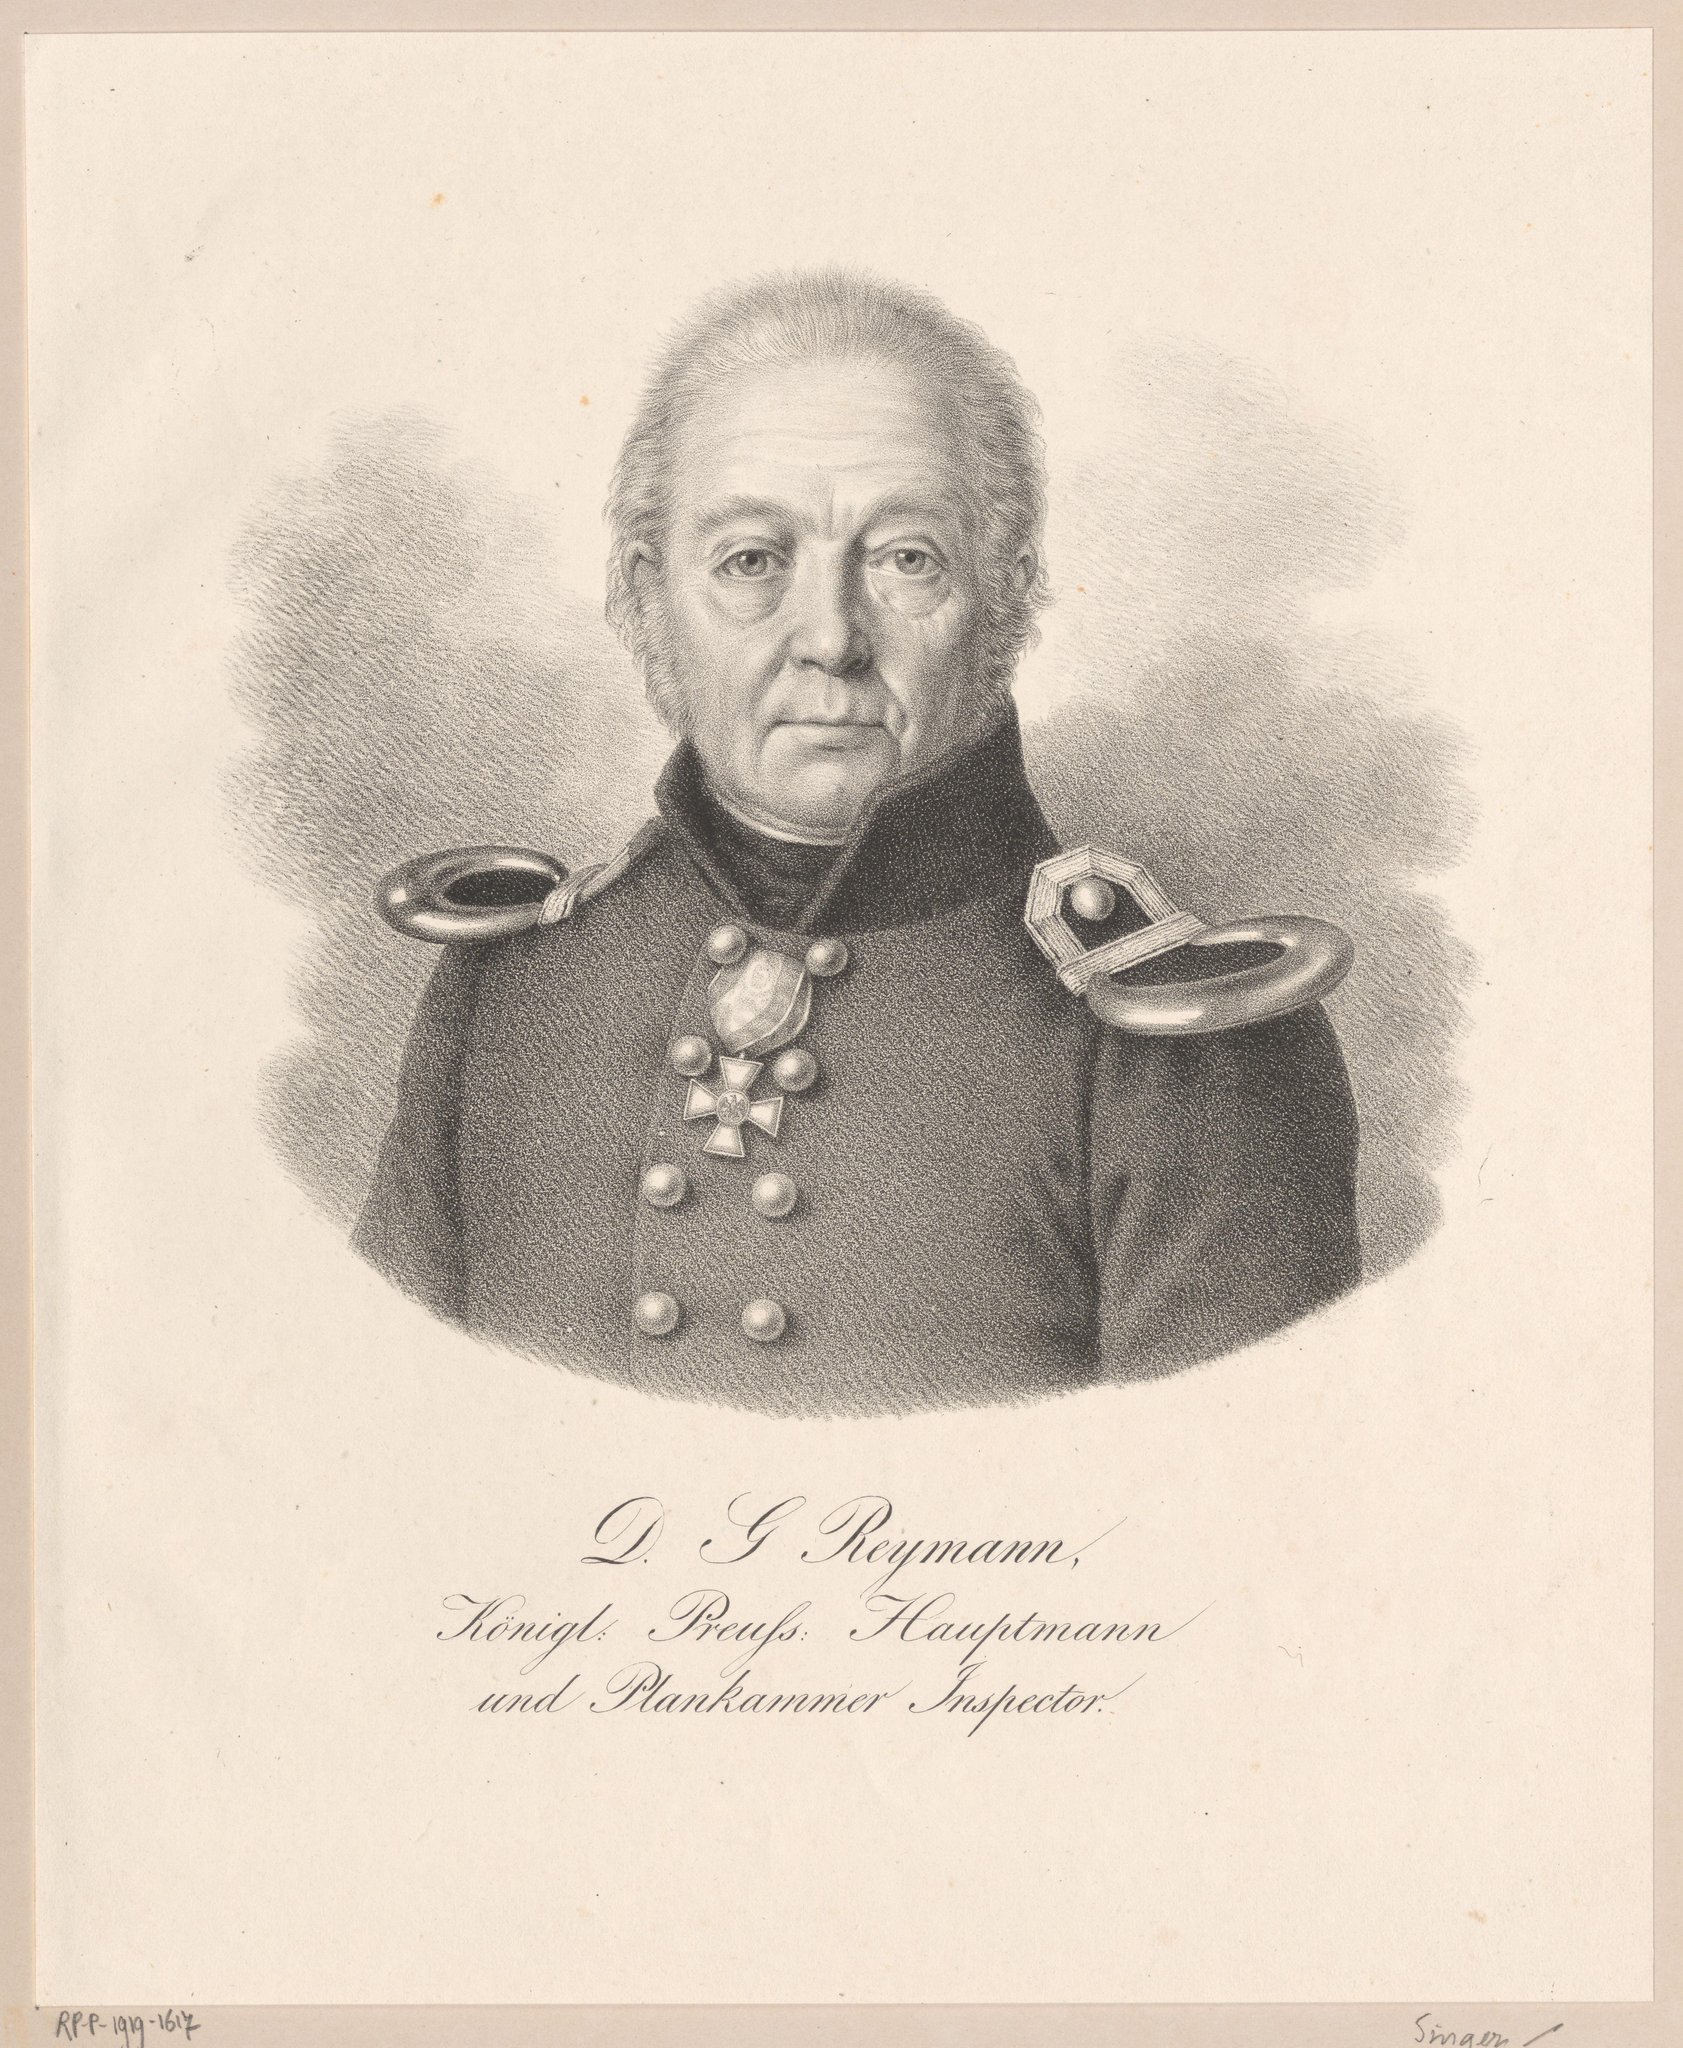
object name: print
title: Portret van Daniel Gottlob Reymann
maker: Anonymous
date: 1837-1849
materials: paper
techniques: lithograph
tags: knighthood order, historical persons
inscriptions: collector's mark: Lugt 2228